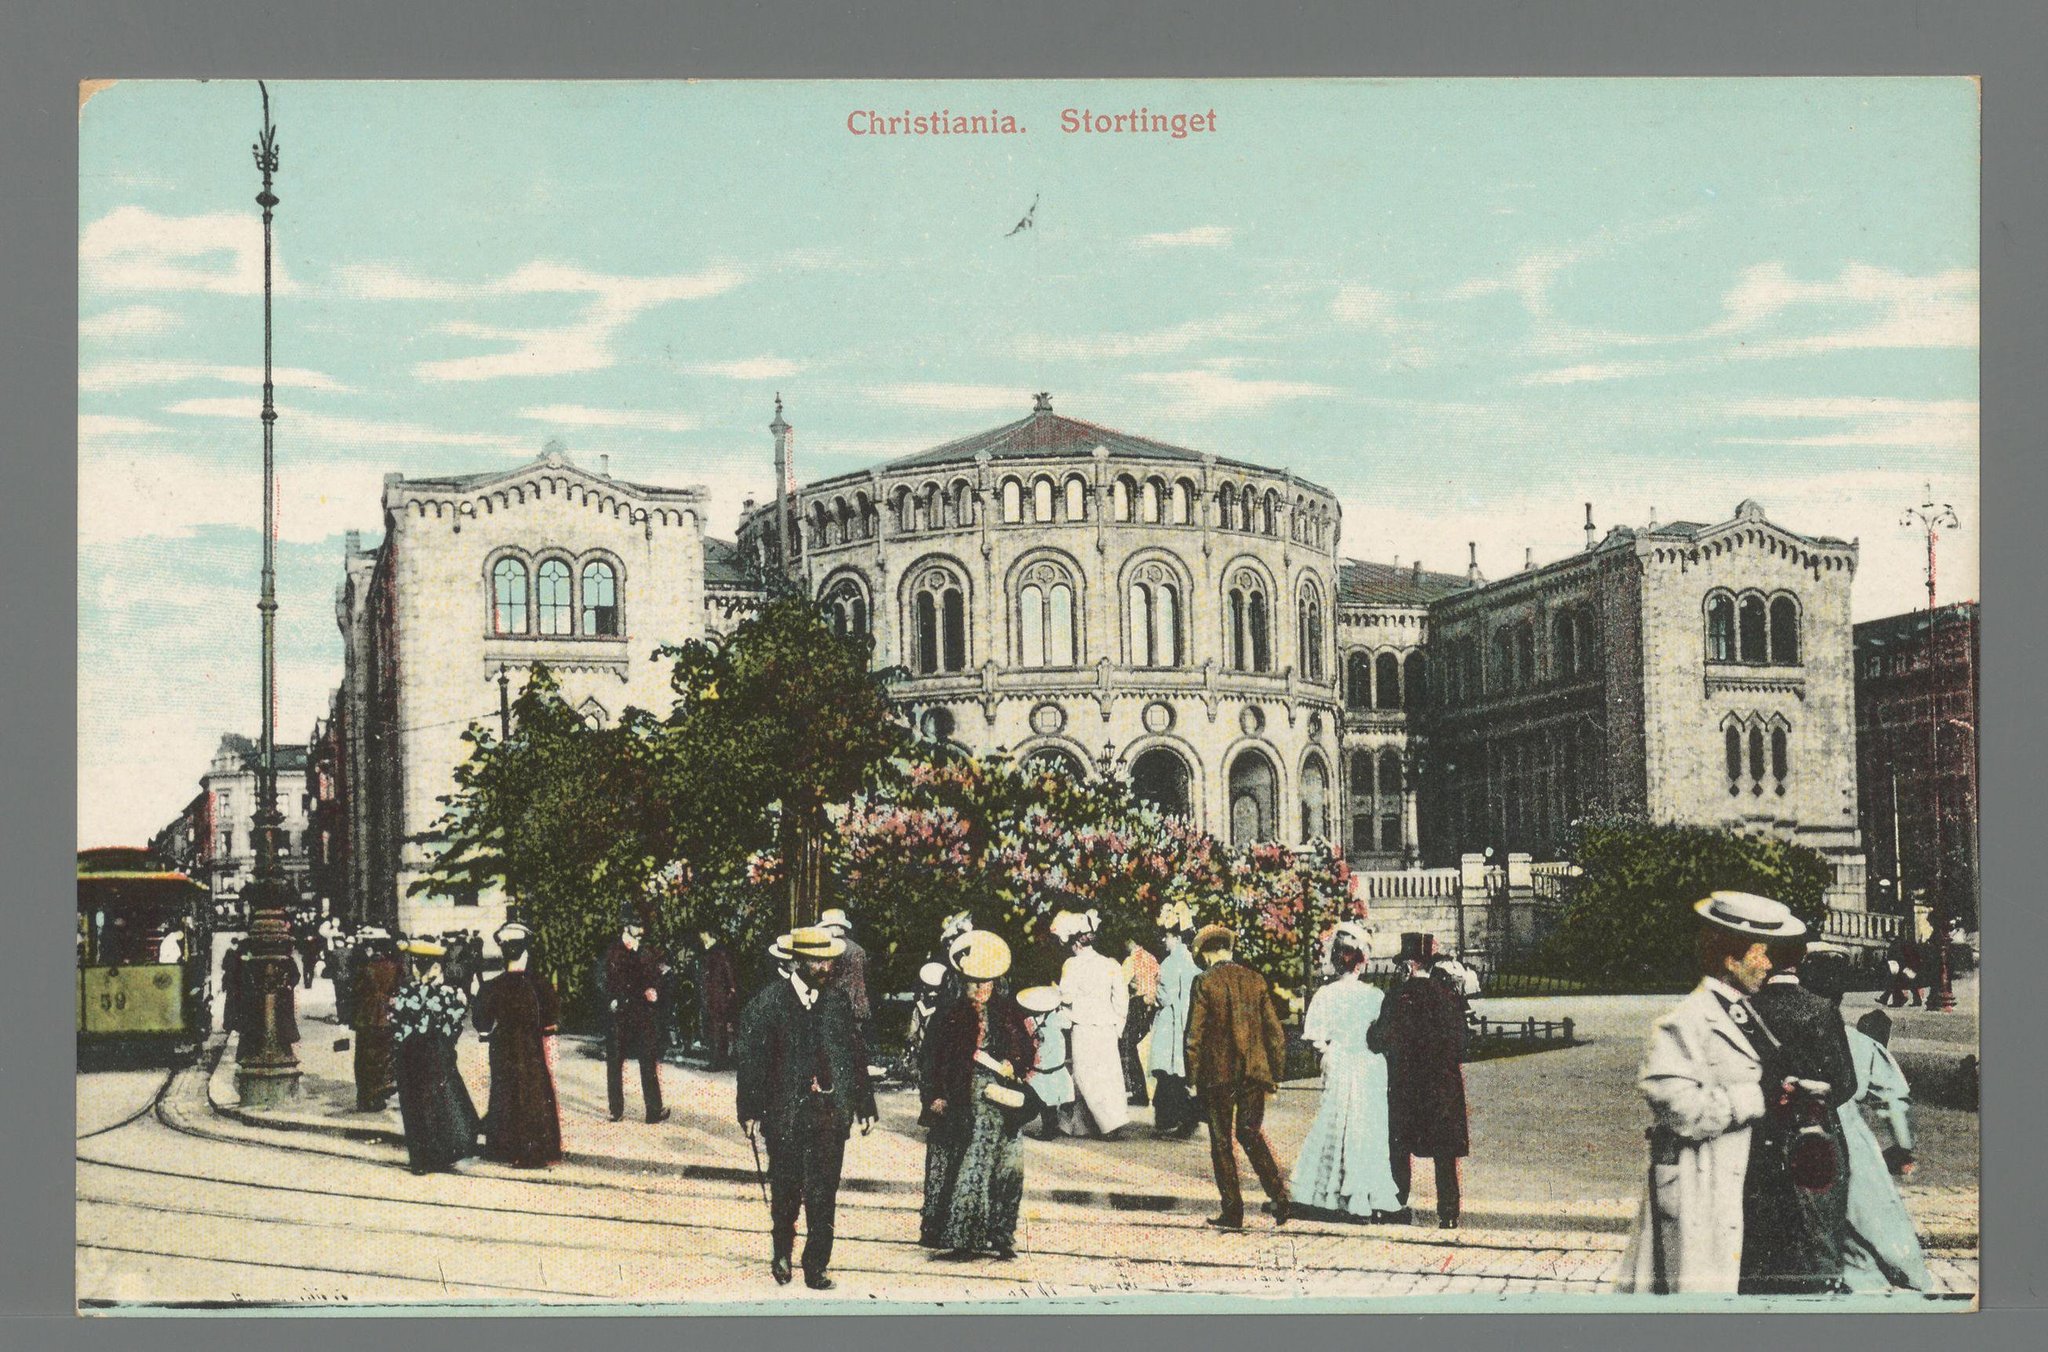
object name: ansichtkaart, prentbriefkaart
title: Christiania. Stortinget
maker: Anonymous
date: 1904-1930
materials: cardboard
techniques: photograph, lithograph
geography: oslo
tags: street, edifice, e.g.: public building, department store